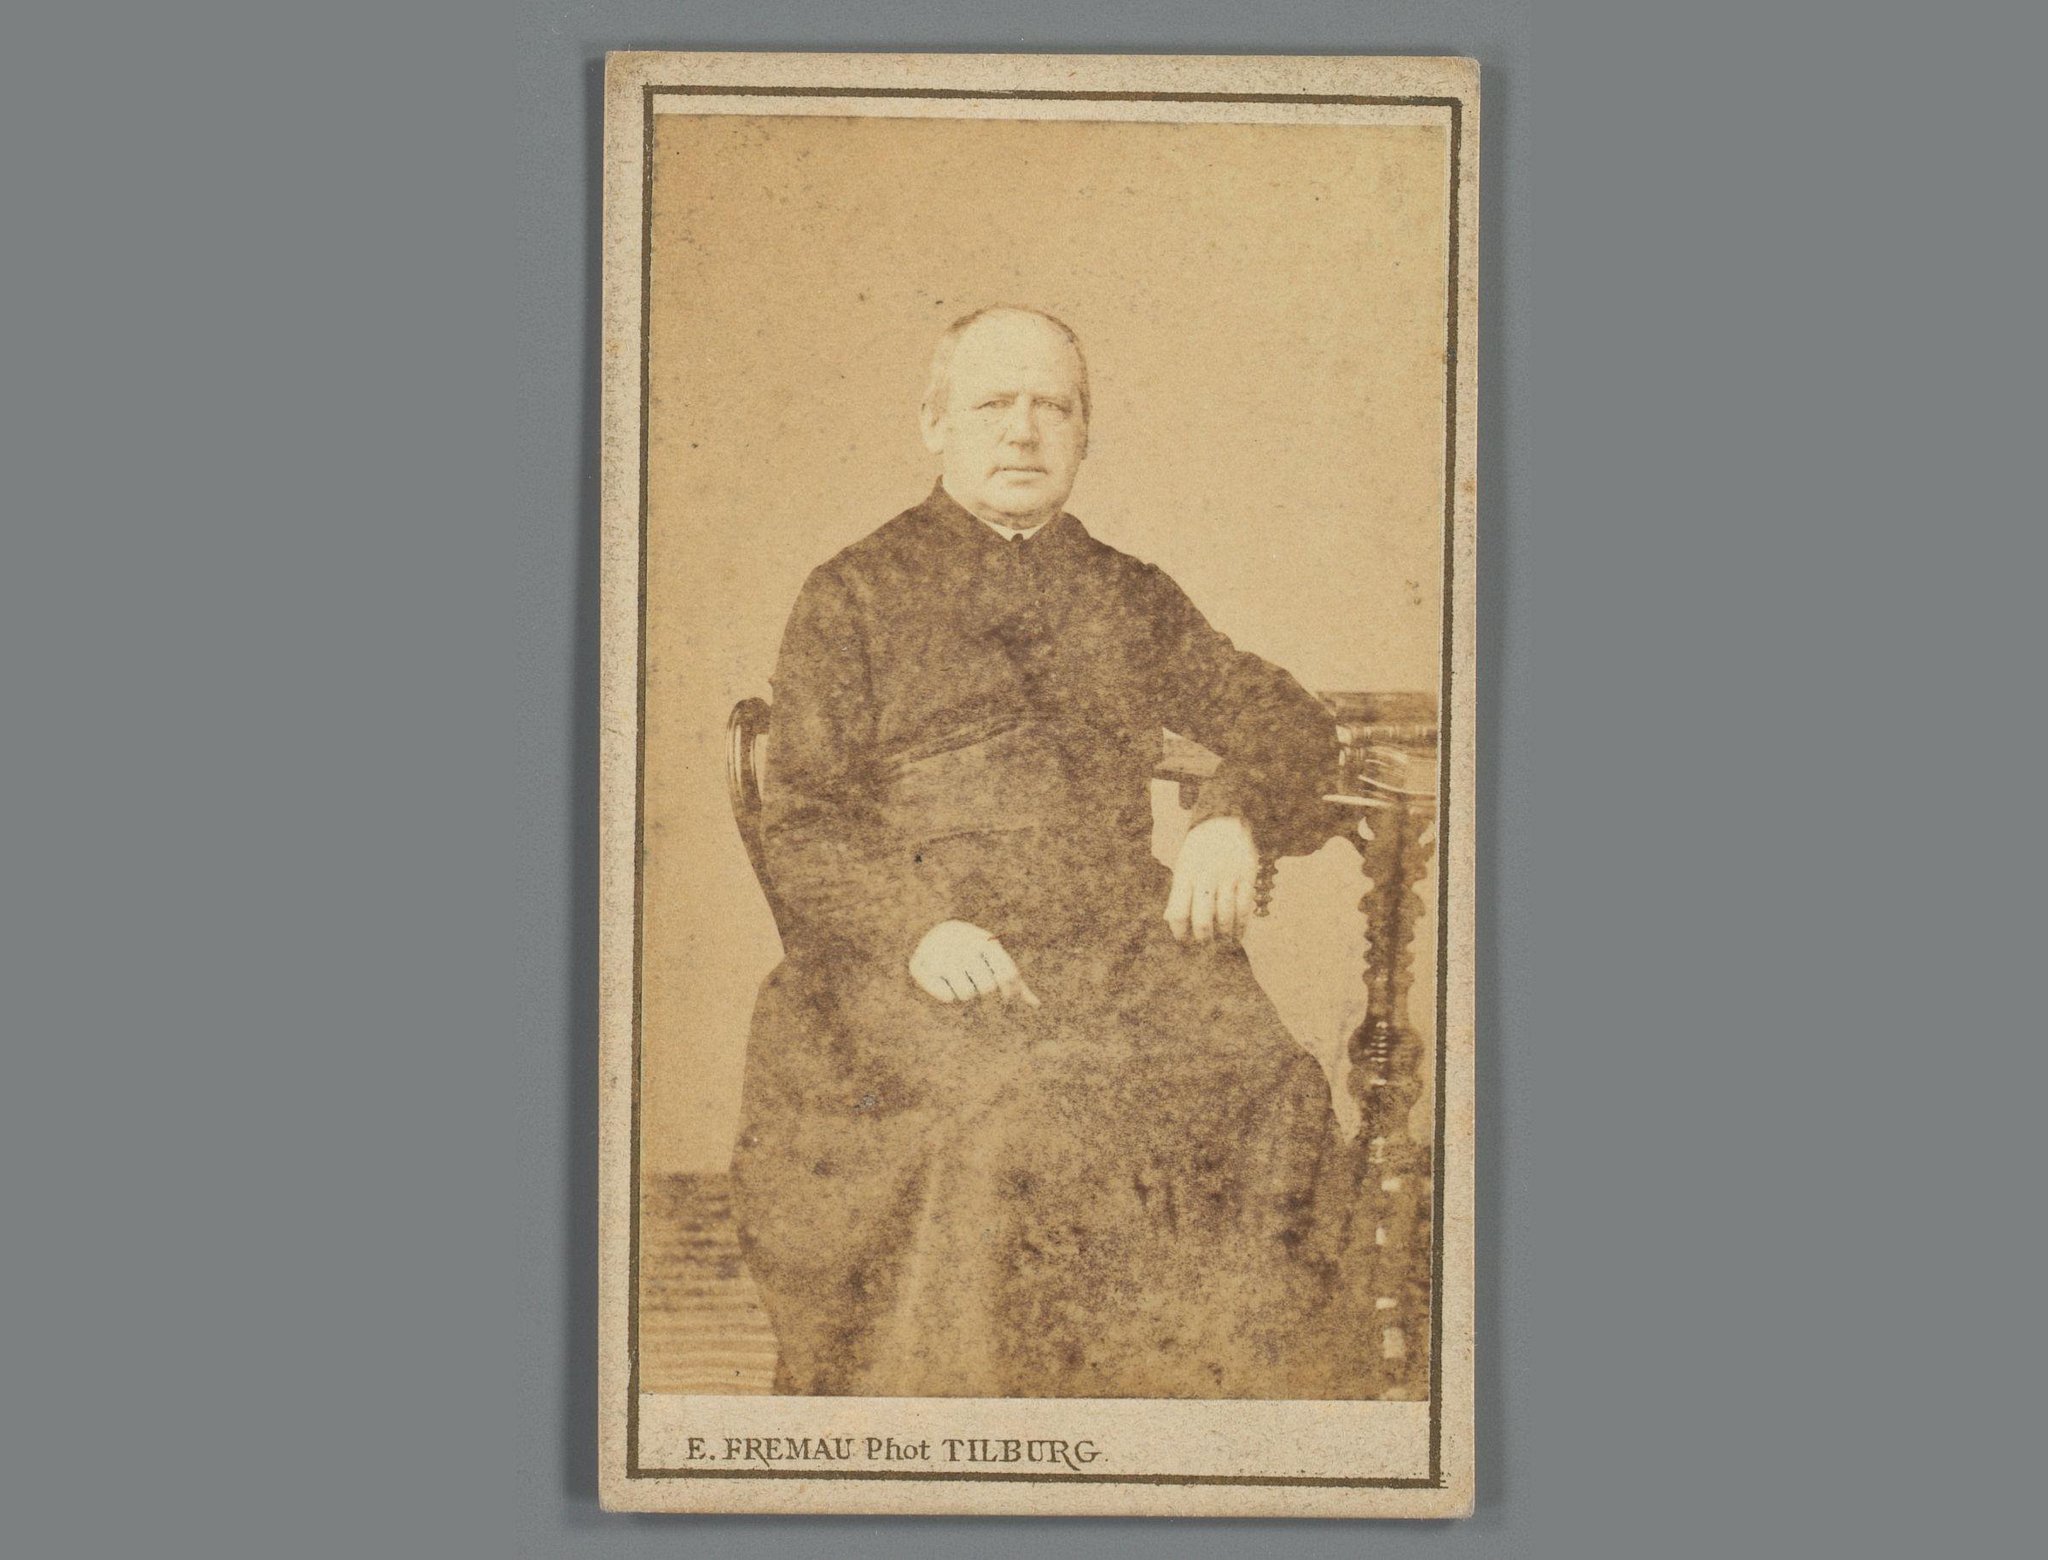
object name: prayer card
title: Portret van Joannes van Schijndel op bidprent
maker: edouard fremau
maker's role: architect, fotograaf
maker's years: 1836-1892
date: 1871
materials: cardboard, paper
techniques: albumen print, letterpress printing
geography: tilburg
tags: priest (roman catholic), historical persons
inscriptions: inscription: ‘E. Fremau Phot. Tilburg’, inscription: ‘Bid voor de ziel van zaliger/ (...) Drukkerij van A. van der Voort & Zonen, Tilburg.’